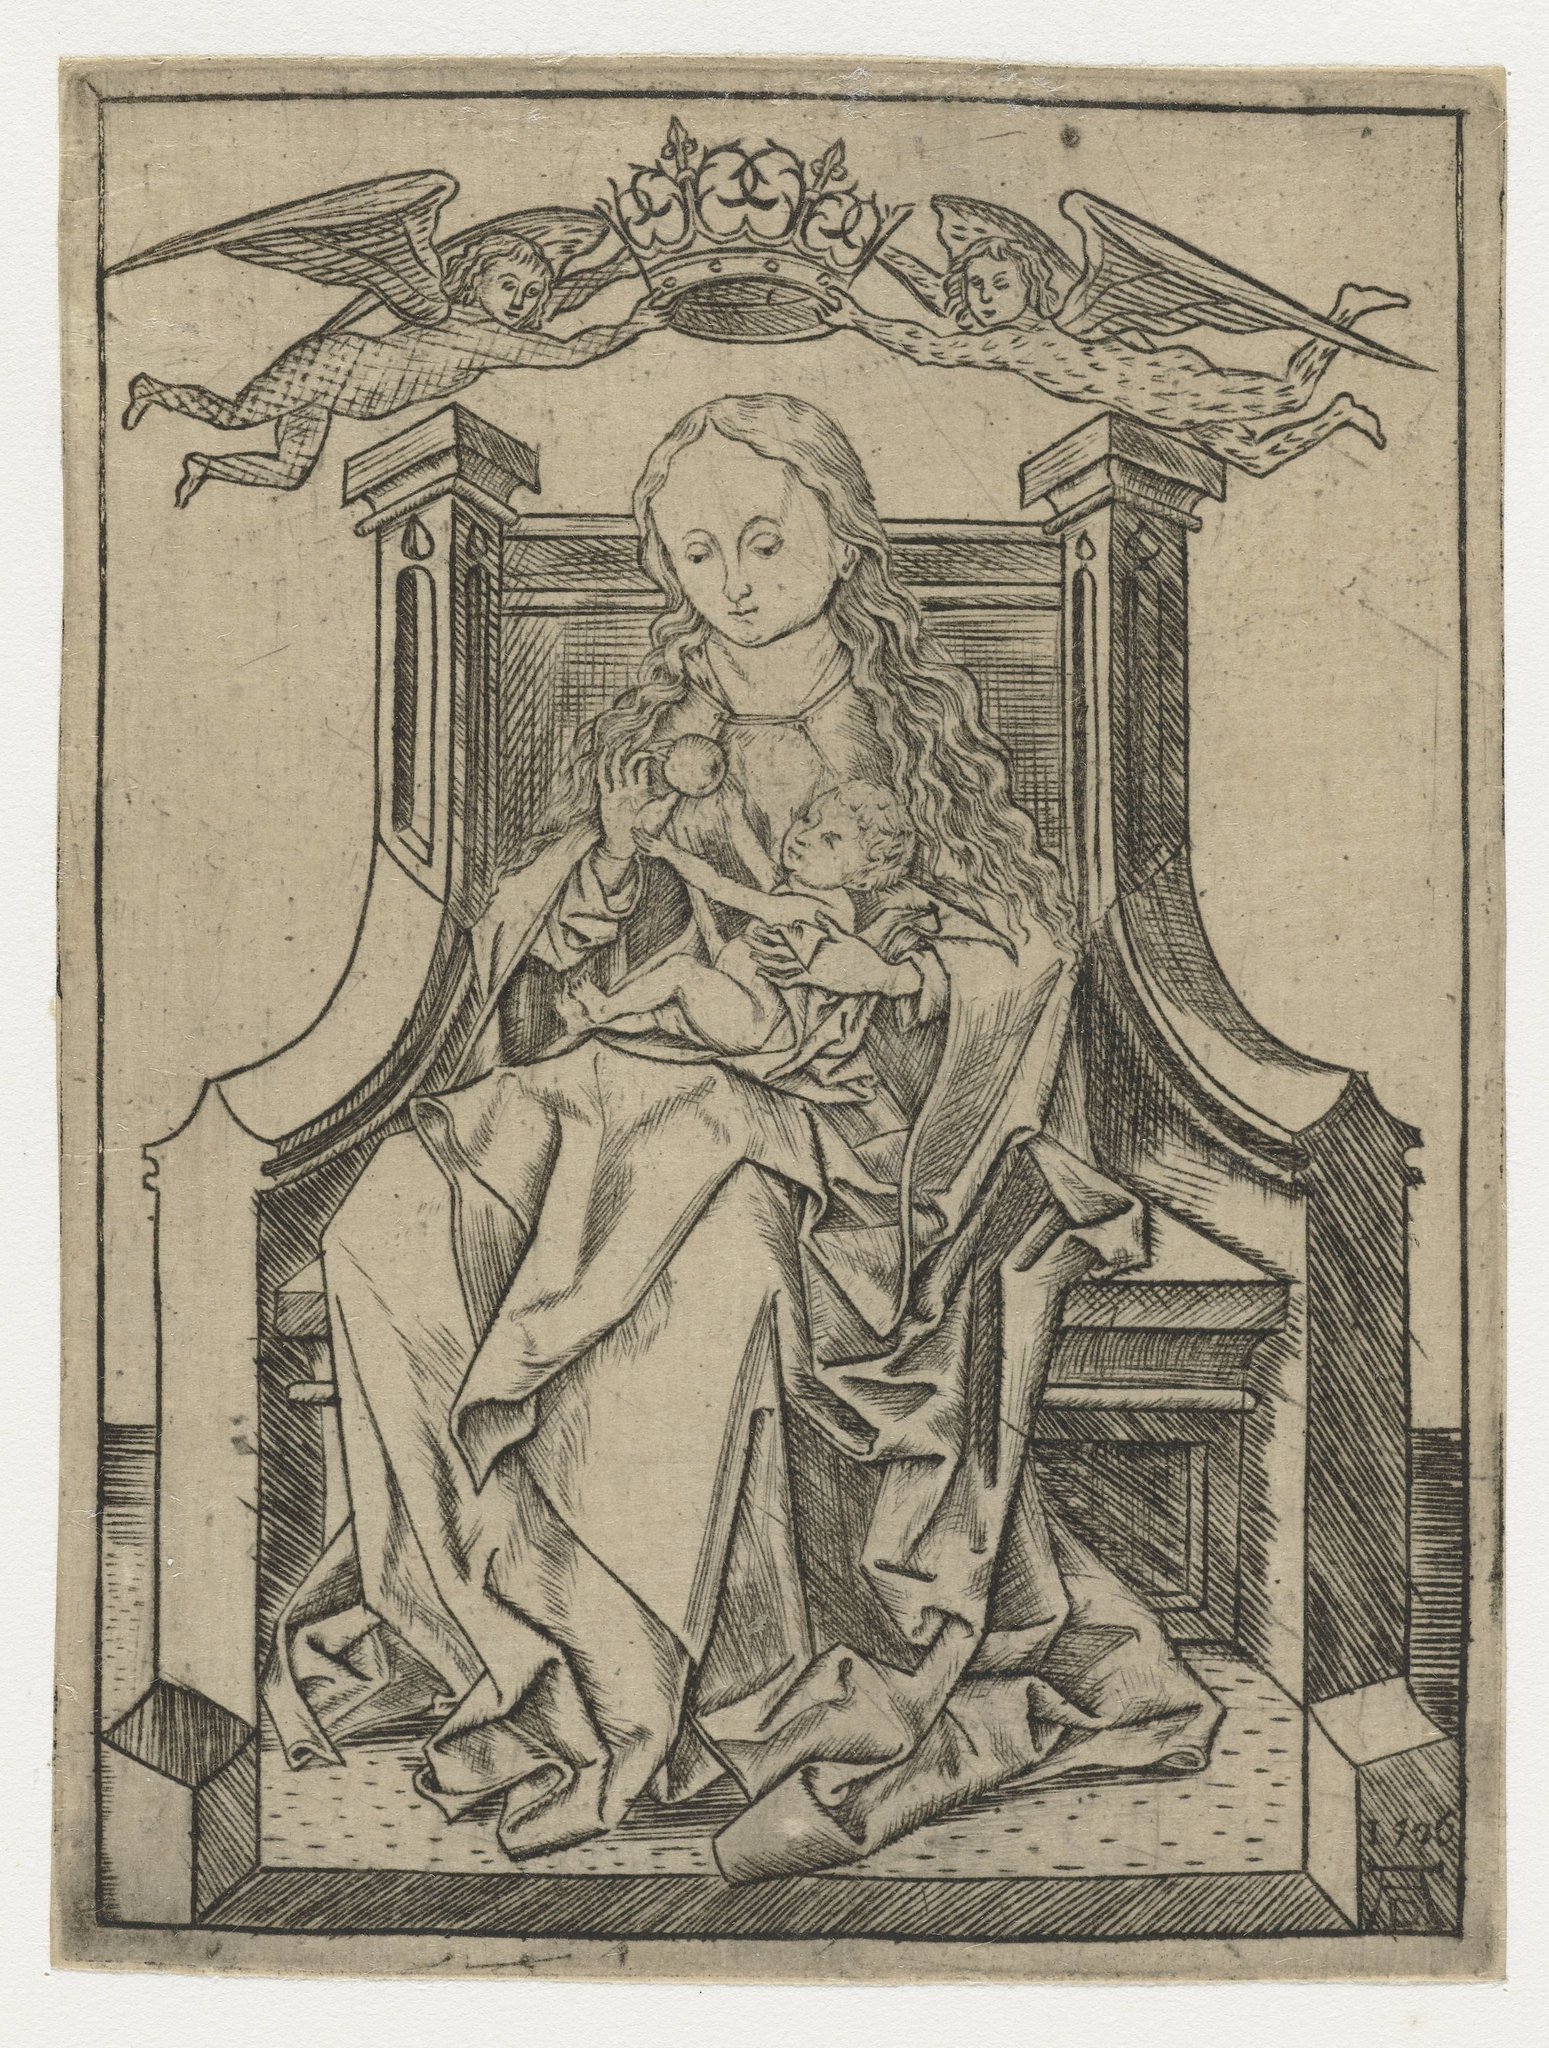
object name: print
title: Maria met Christus en een appel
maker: albrecht dürer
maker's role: draughtsman, painter, print maker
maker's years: 1471-1528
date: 1496-1525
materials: paper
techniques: engraving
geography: nuremberg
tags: madonna: mary sitting or enthroned, the christ-child in her lap (or in front of her bosom) (mary sometimes represented half-length), christ-child accepting, reaching out for something ~ madonna-representations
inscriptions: collector's mark: Lugt 240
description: Maria zit op een troon met het Christuskind op schoot. Ze houdt het een appel voor. Twee engelen houden een kroon boven haar hoofd.